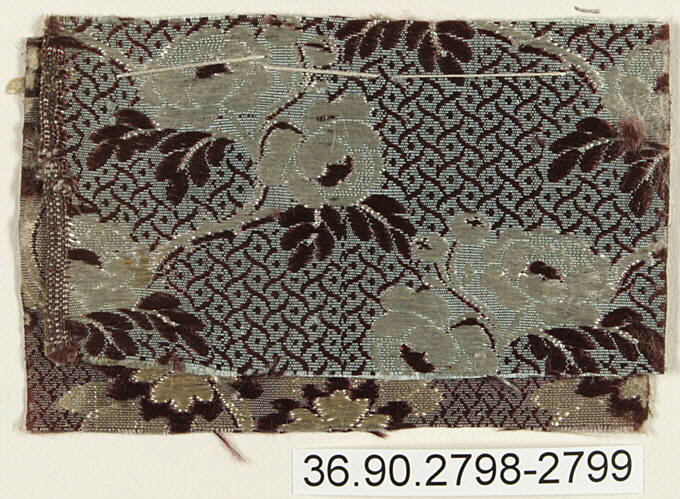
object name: piece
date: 1801-1900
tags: flowers